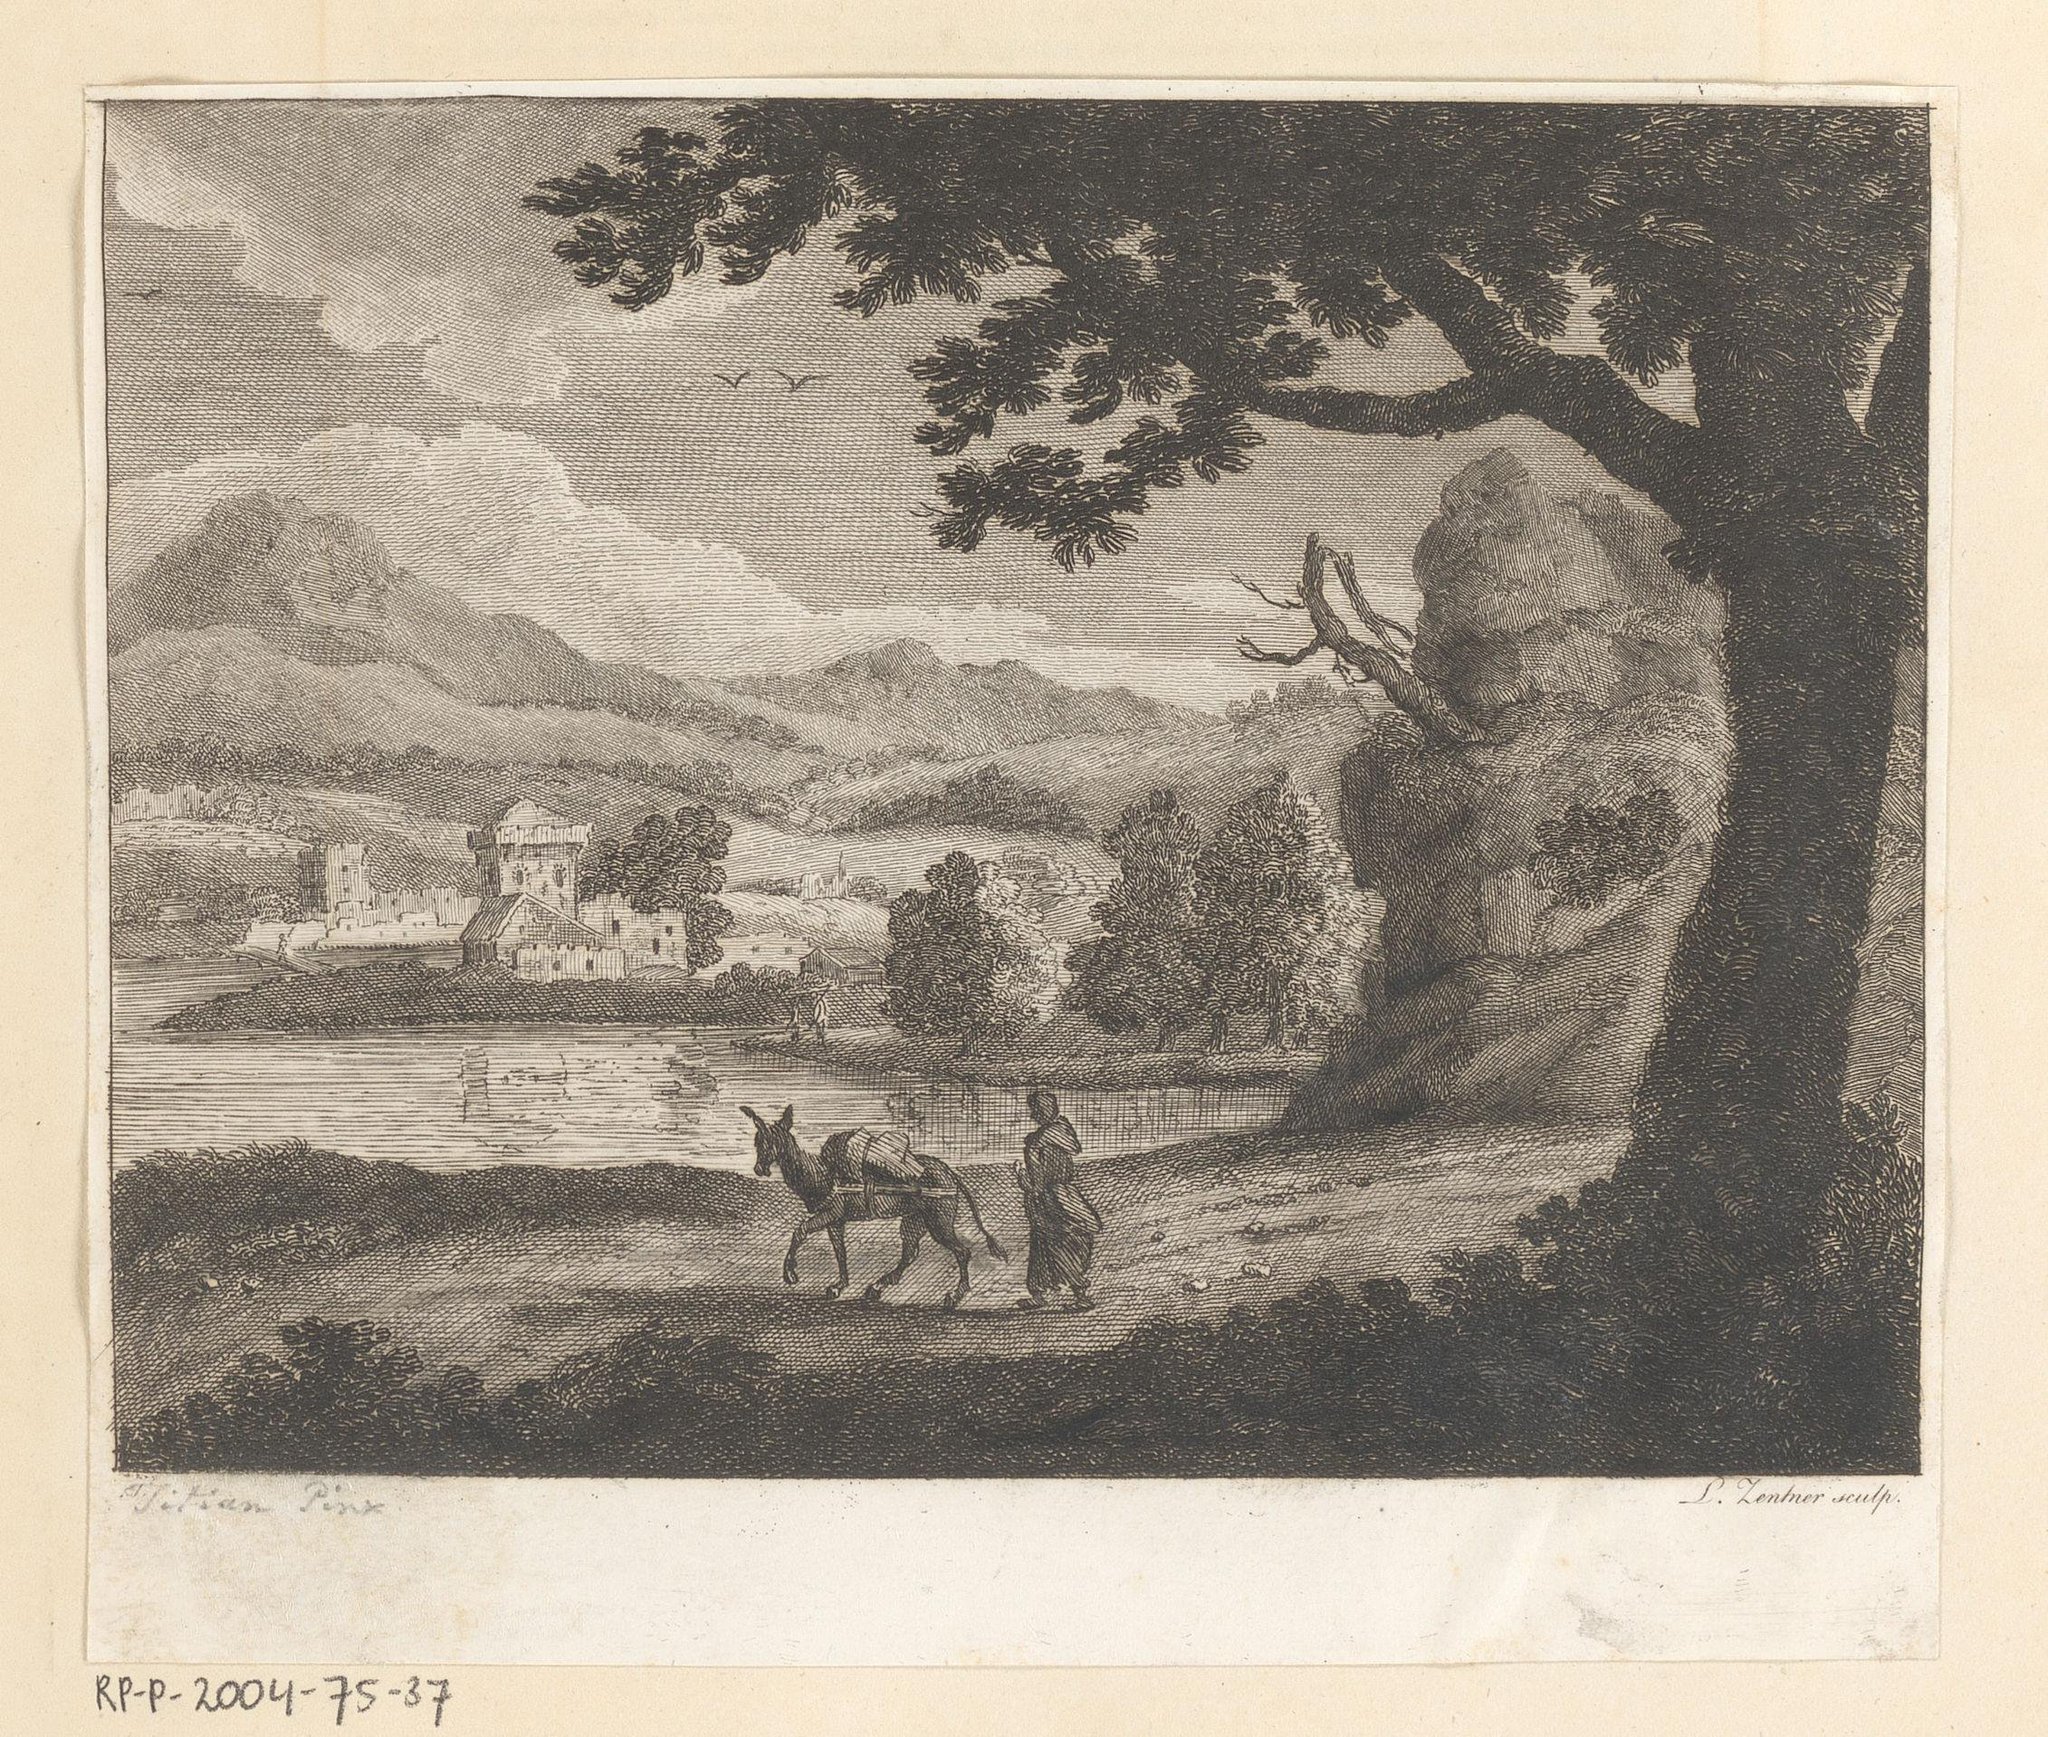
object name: print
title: Landschap met reiziger met ezel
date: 1791-1798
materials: paper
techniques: engraving, etching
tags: ass, donkey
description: Deze prent is niet opgenomen in de uitgave: Zentner, L. A select Collection of landscapes from the best old masters (...). London: J. Thane, 1791. De samensteller heeft deze prent in het album geplakt als illustratie bij: Pilkington, Matthew en Johann Heinrich Füssli. A dictionary of painters, from the revival of the art to the present period. 4 dln. Londen: John Crowder, 1805, dl. 4, p. 572.